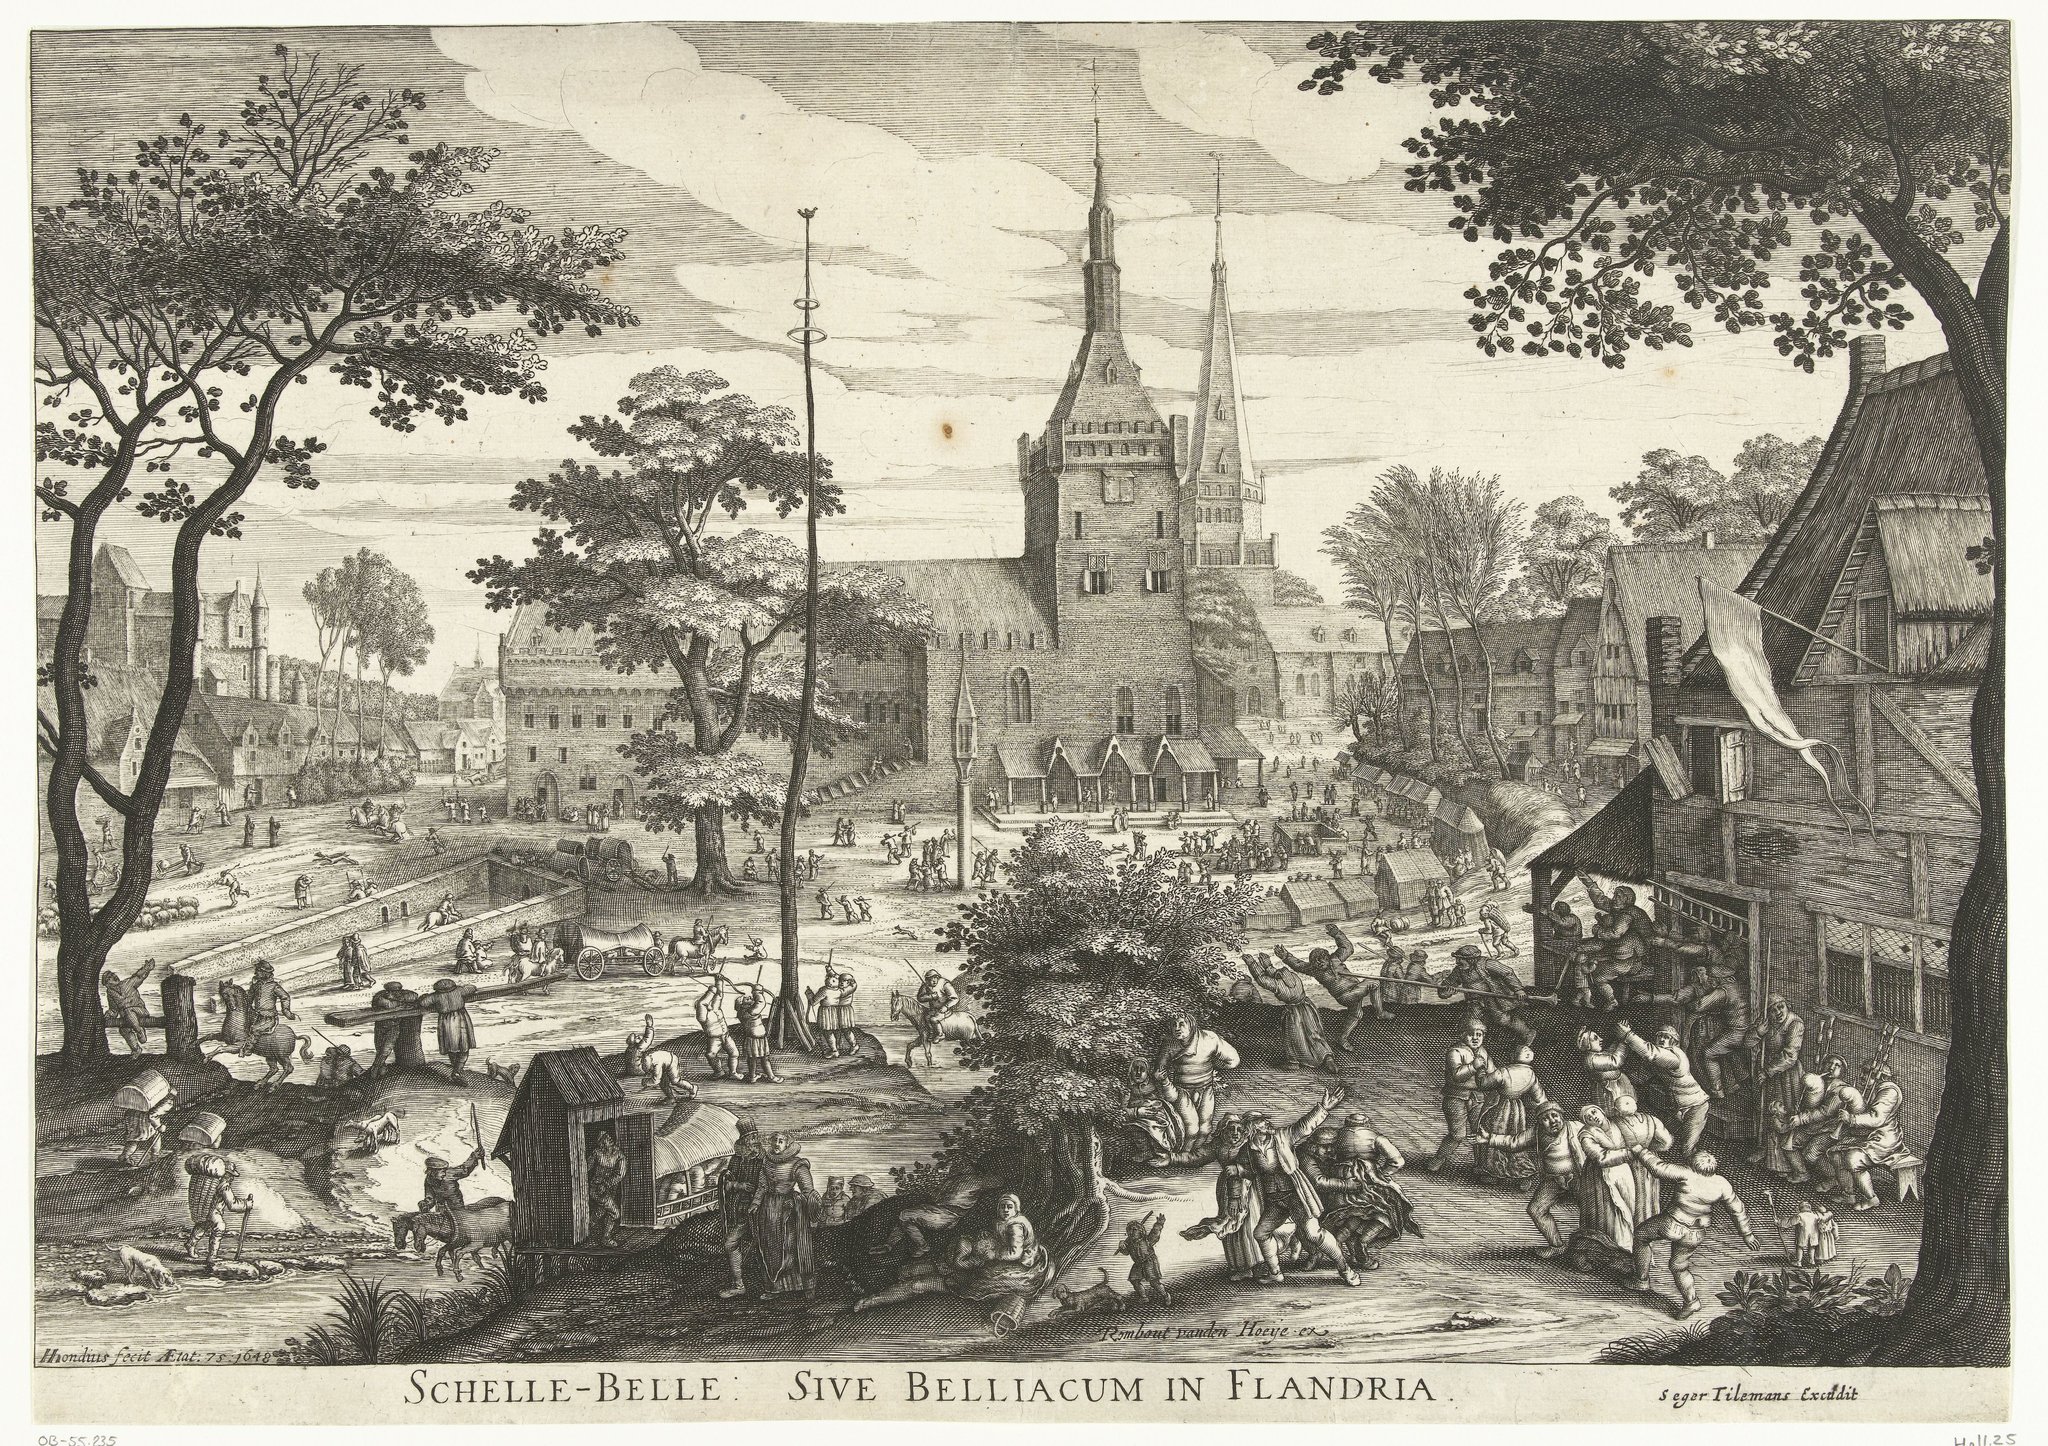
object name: print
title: Schelle-Belle: Sive Belliacum in Flandria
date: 1648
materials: paper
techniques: engraving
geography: amsterdam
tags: farmers, public festivities, shooting-the-bird (on a high pole)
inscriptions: collector's mark: Lugt 2228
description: Dorpsfeest in Belle (het huidige Bailleul) in Frankrijk. Gezicht op een dorp met dansende en drinkende boeren voor een herberg, rechts op de voorgrond. In het midden zijn enkele figuren aan het vogelschieten. Op de achtergrond een kerk en het belfort, waarvoor kraampjes staan opgesteld.